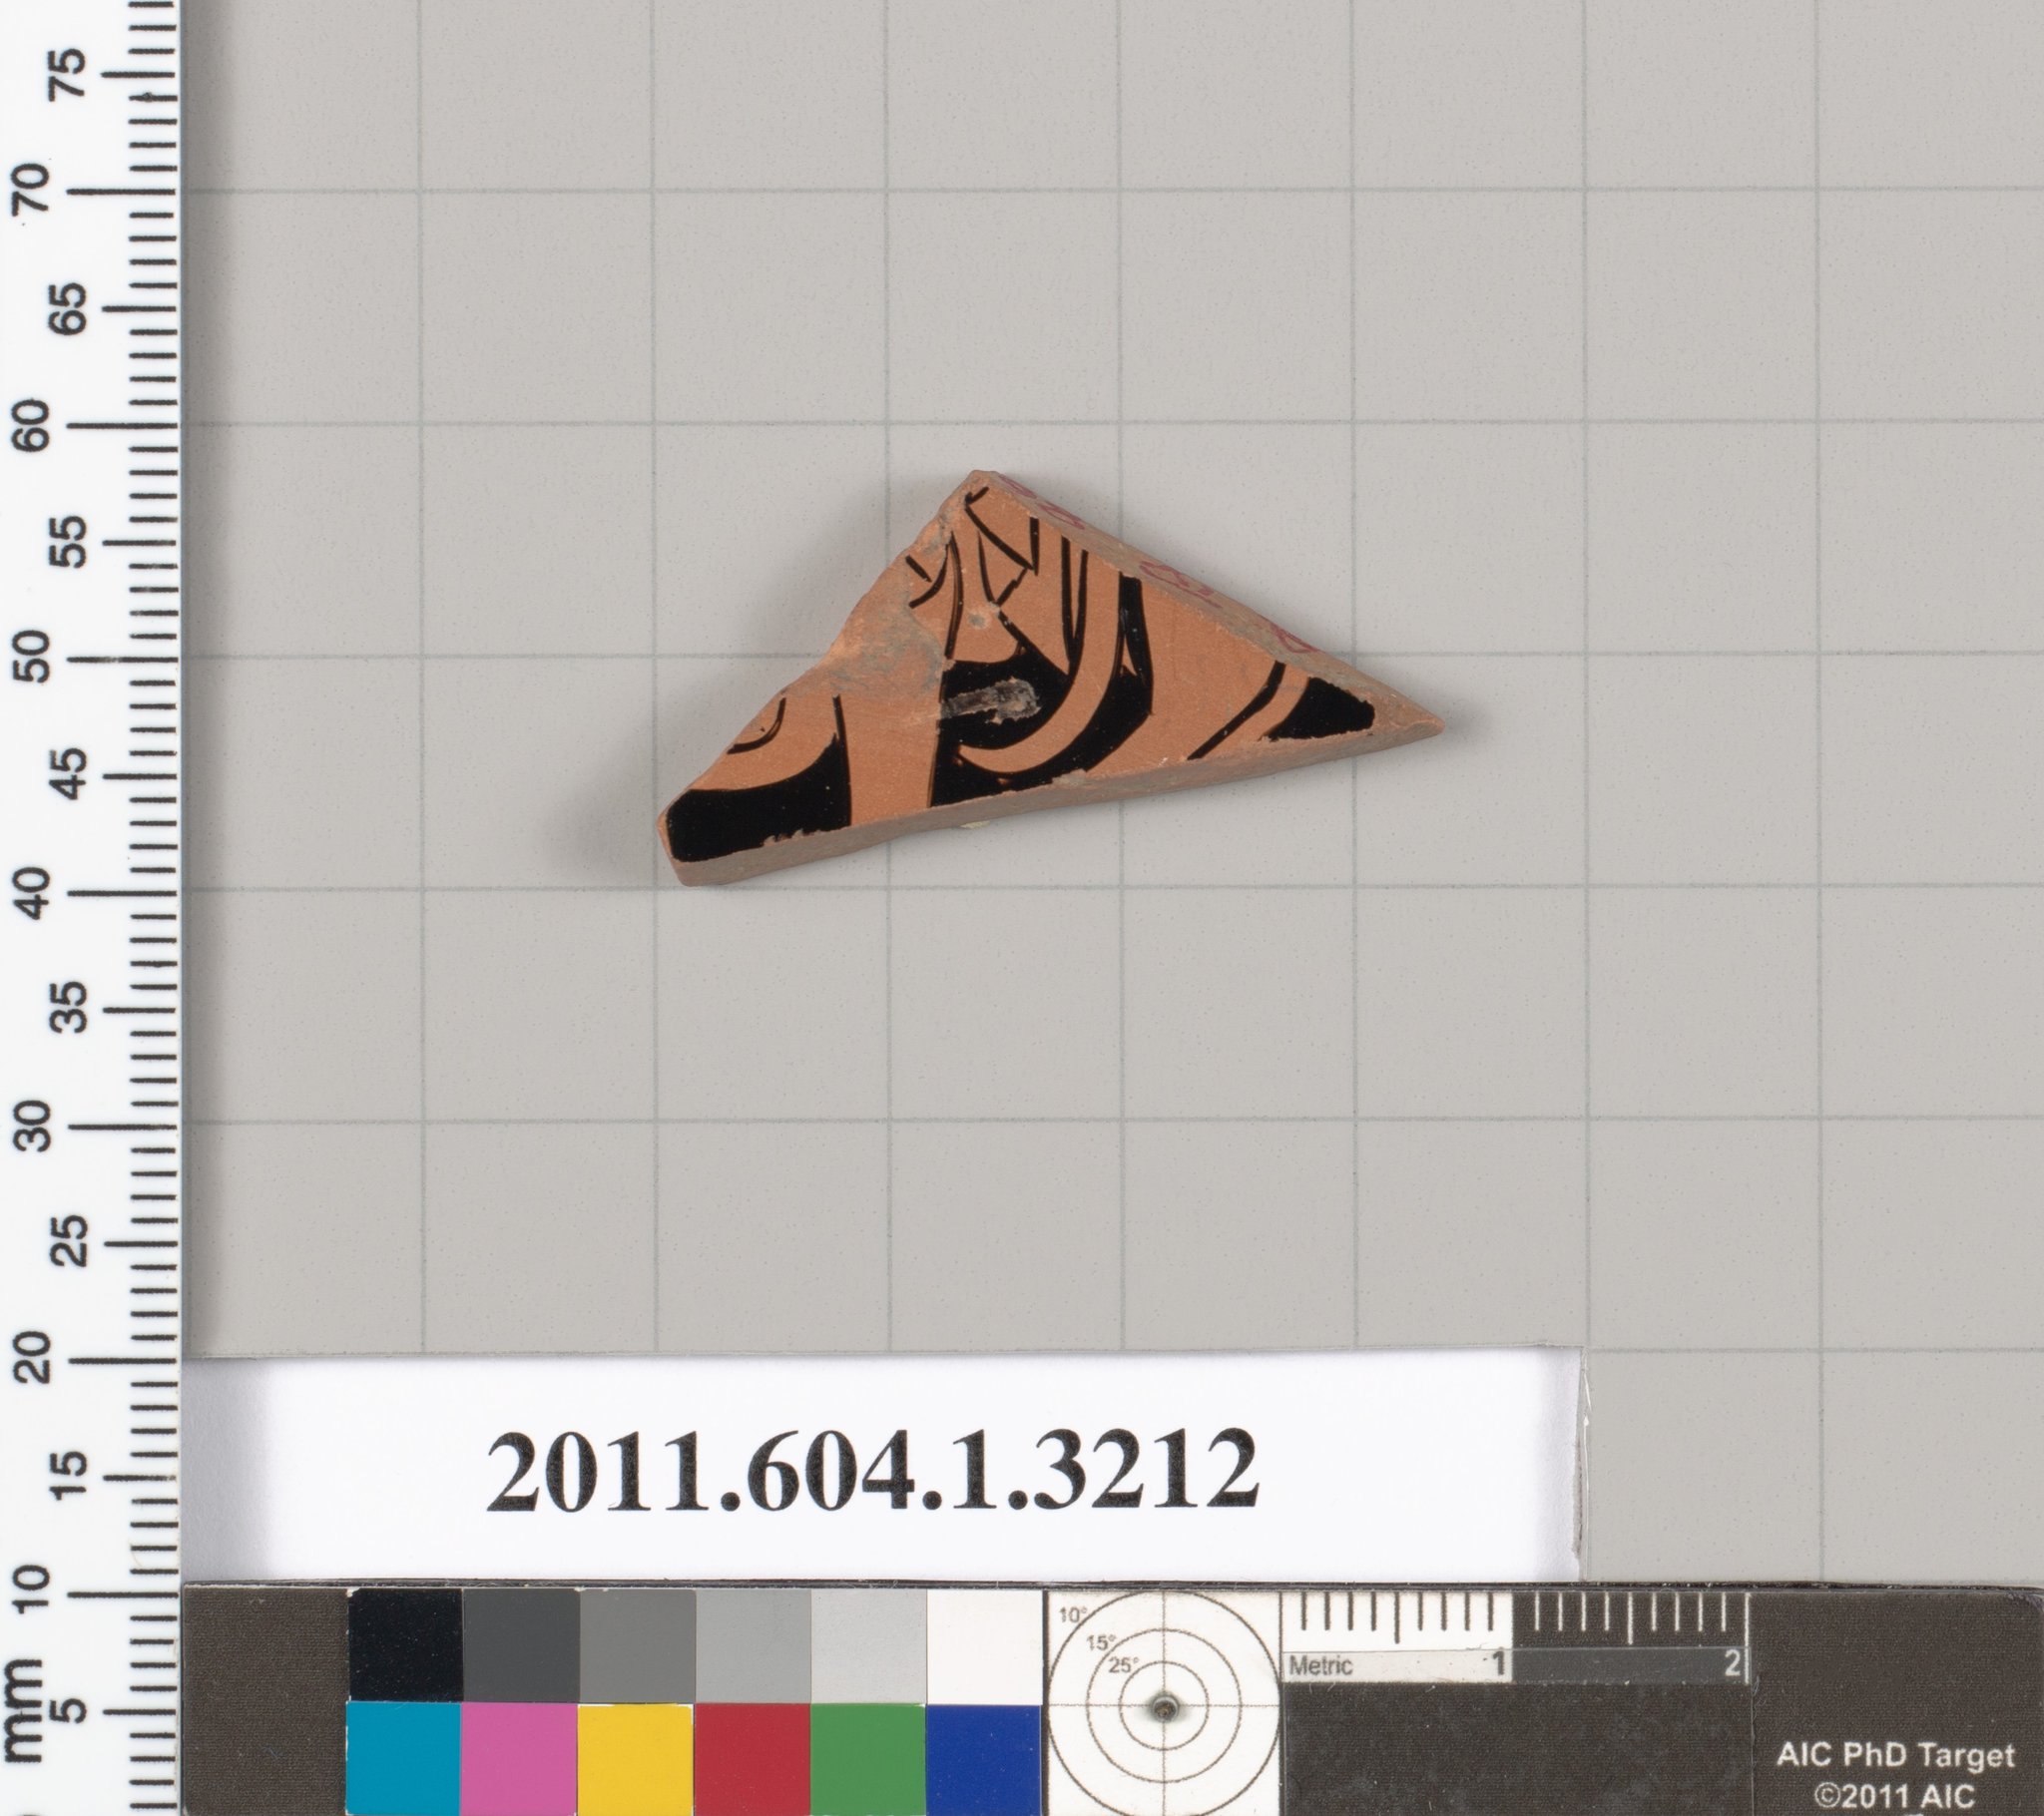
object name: kylix fragment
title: Terracotta fragment of a kylix (drinking cup)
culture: greek, attic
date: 490-480 BCE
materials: terracotta